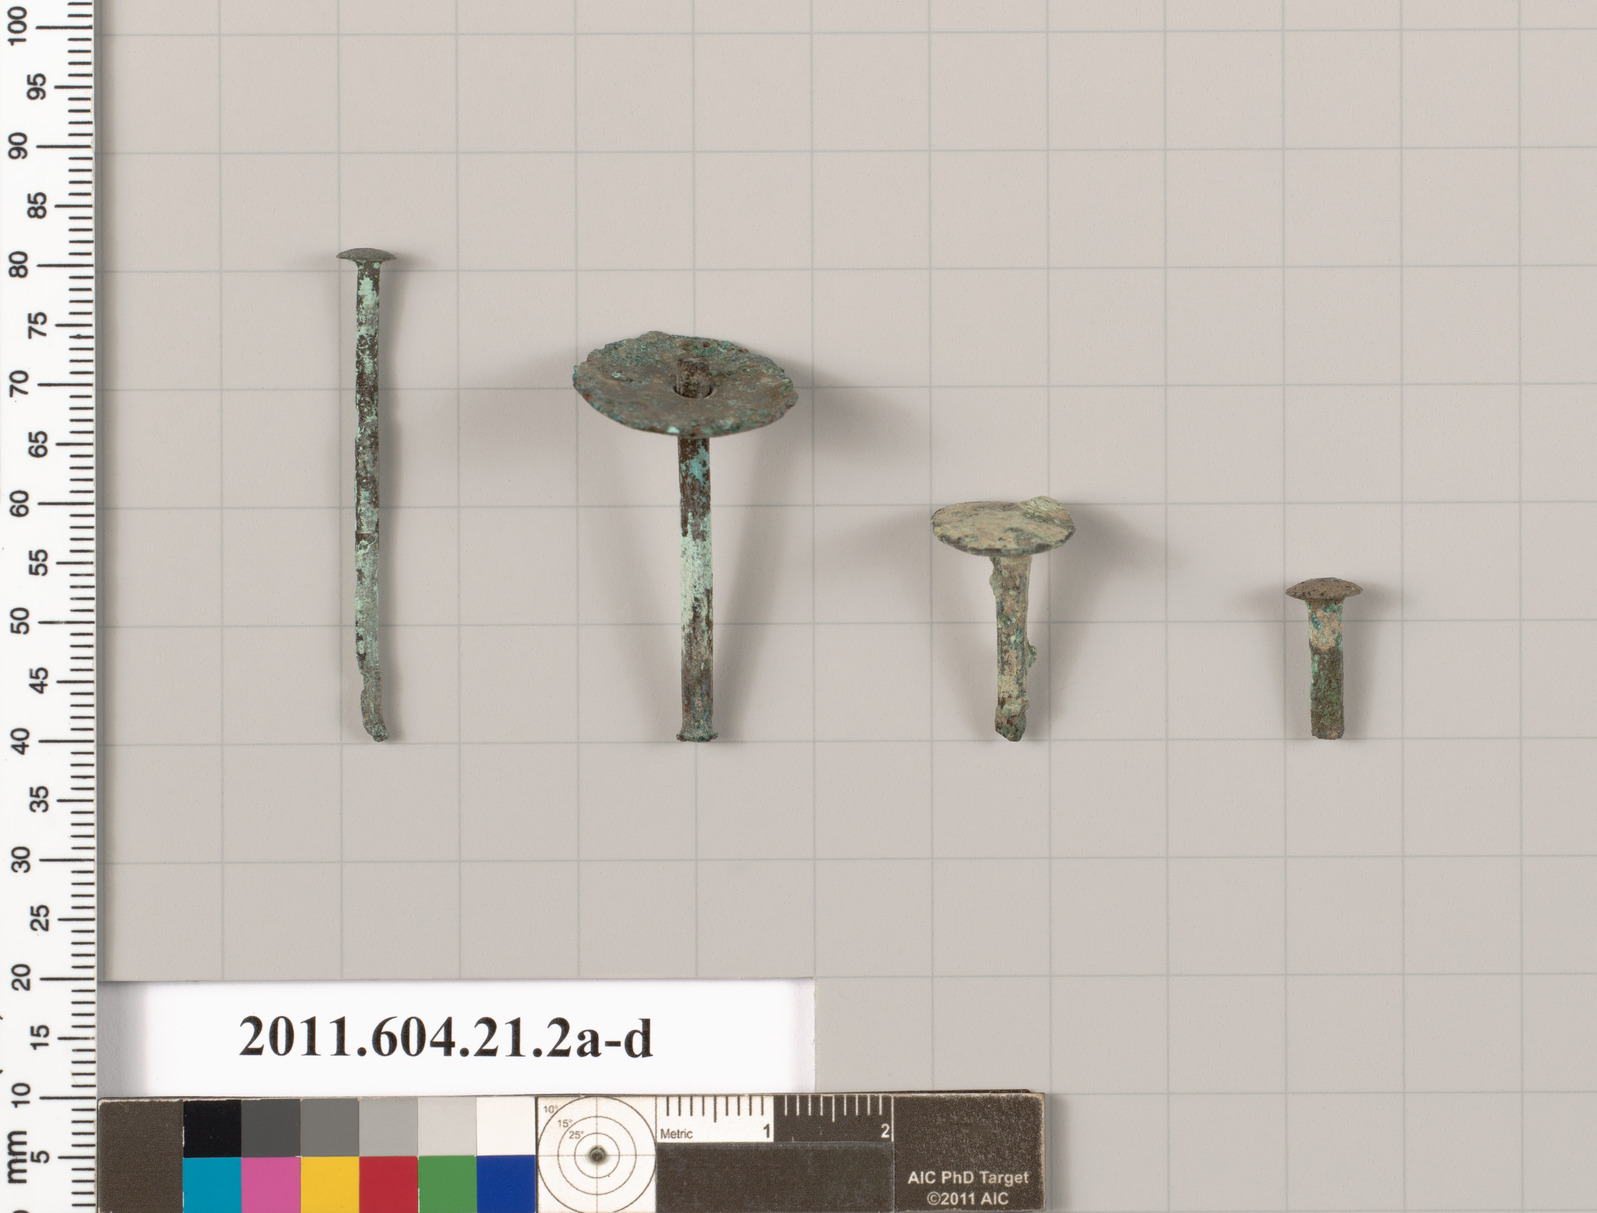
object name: bronze nail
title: Bronze nails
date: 700-501 BCE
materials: bronze